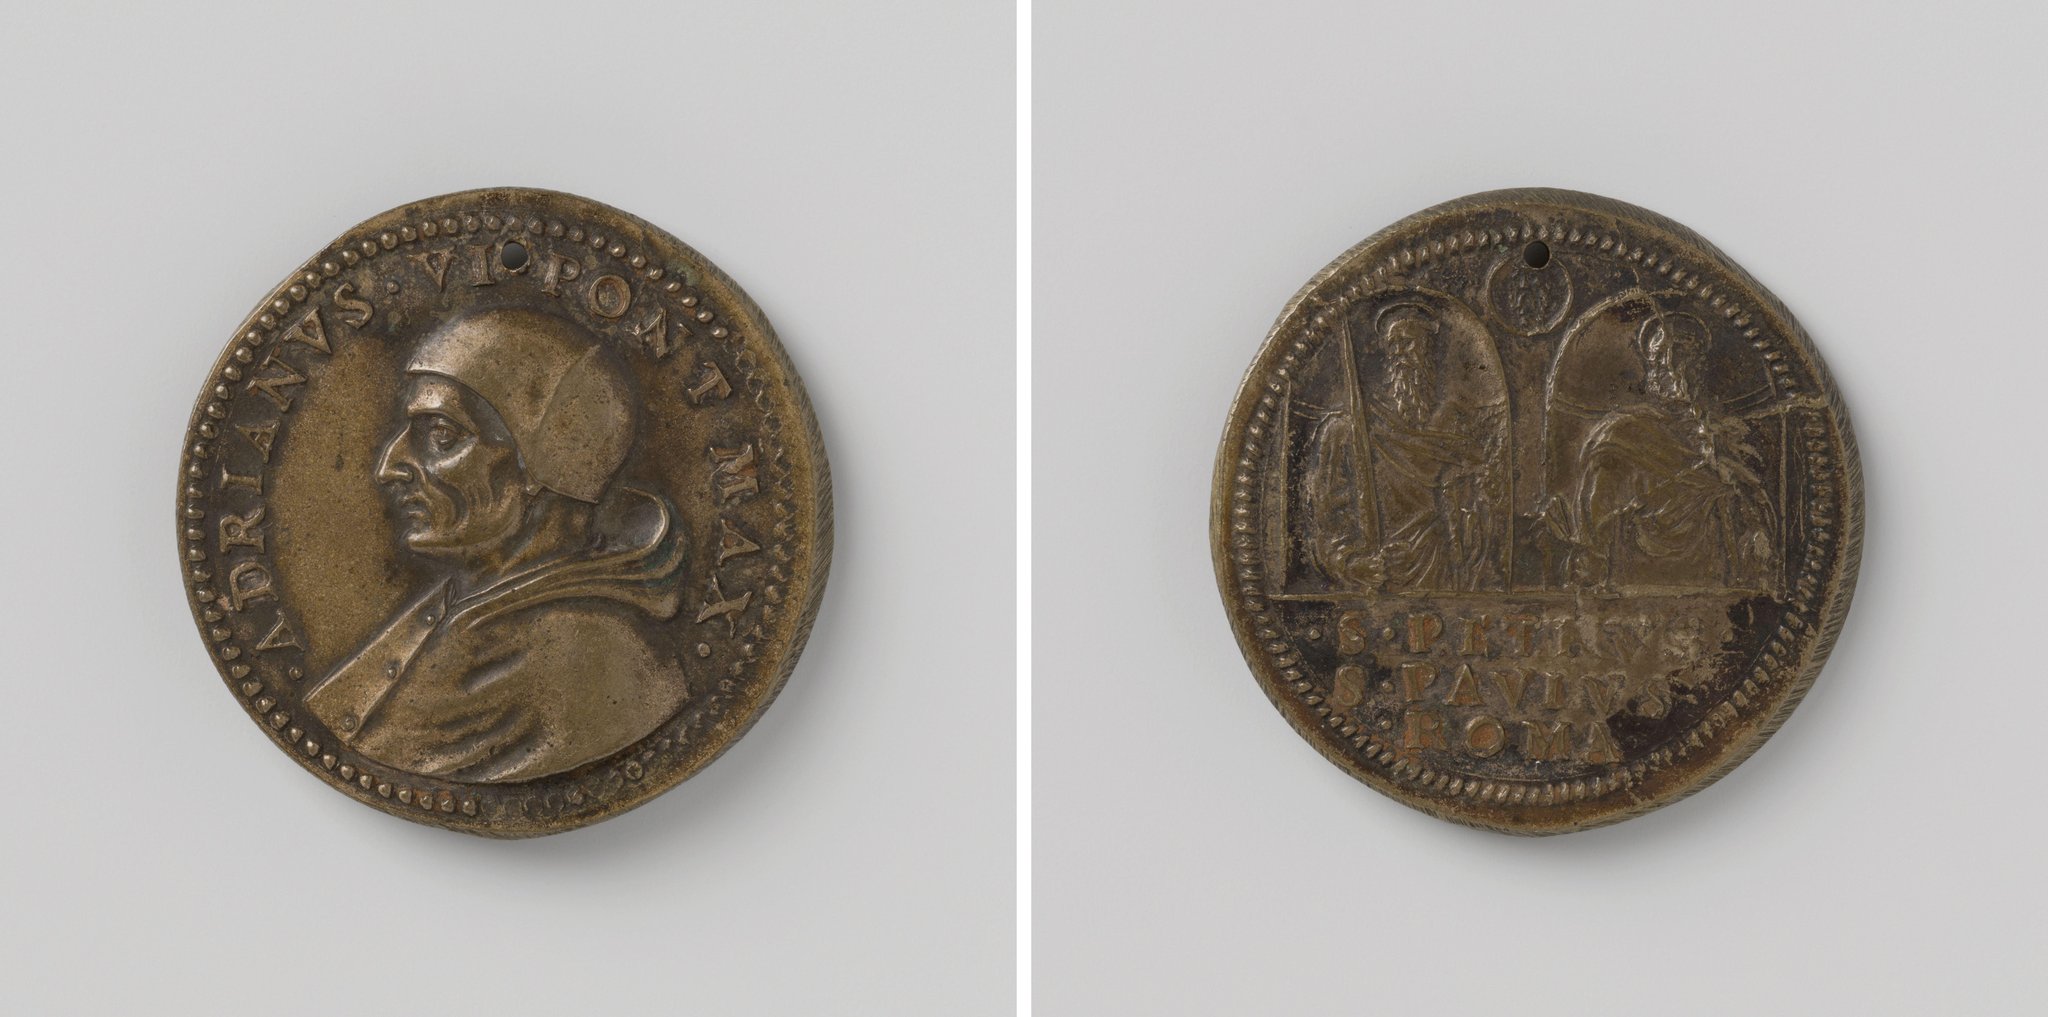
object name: history medal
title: Paus Adrianus VI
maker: Anonymous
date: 1522-1523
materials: bronze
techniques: striking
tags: utrecht, rome, clergyman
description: Bronzen penning met gat erin. Voorzijde: borststuk man met muts binnen omschrift. Keerzijde: Paulus met zwaard en Petrus met sleutels; afsnede: opschrift